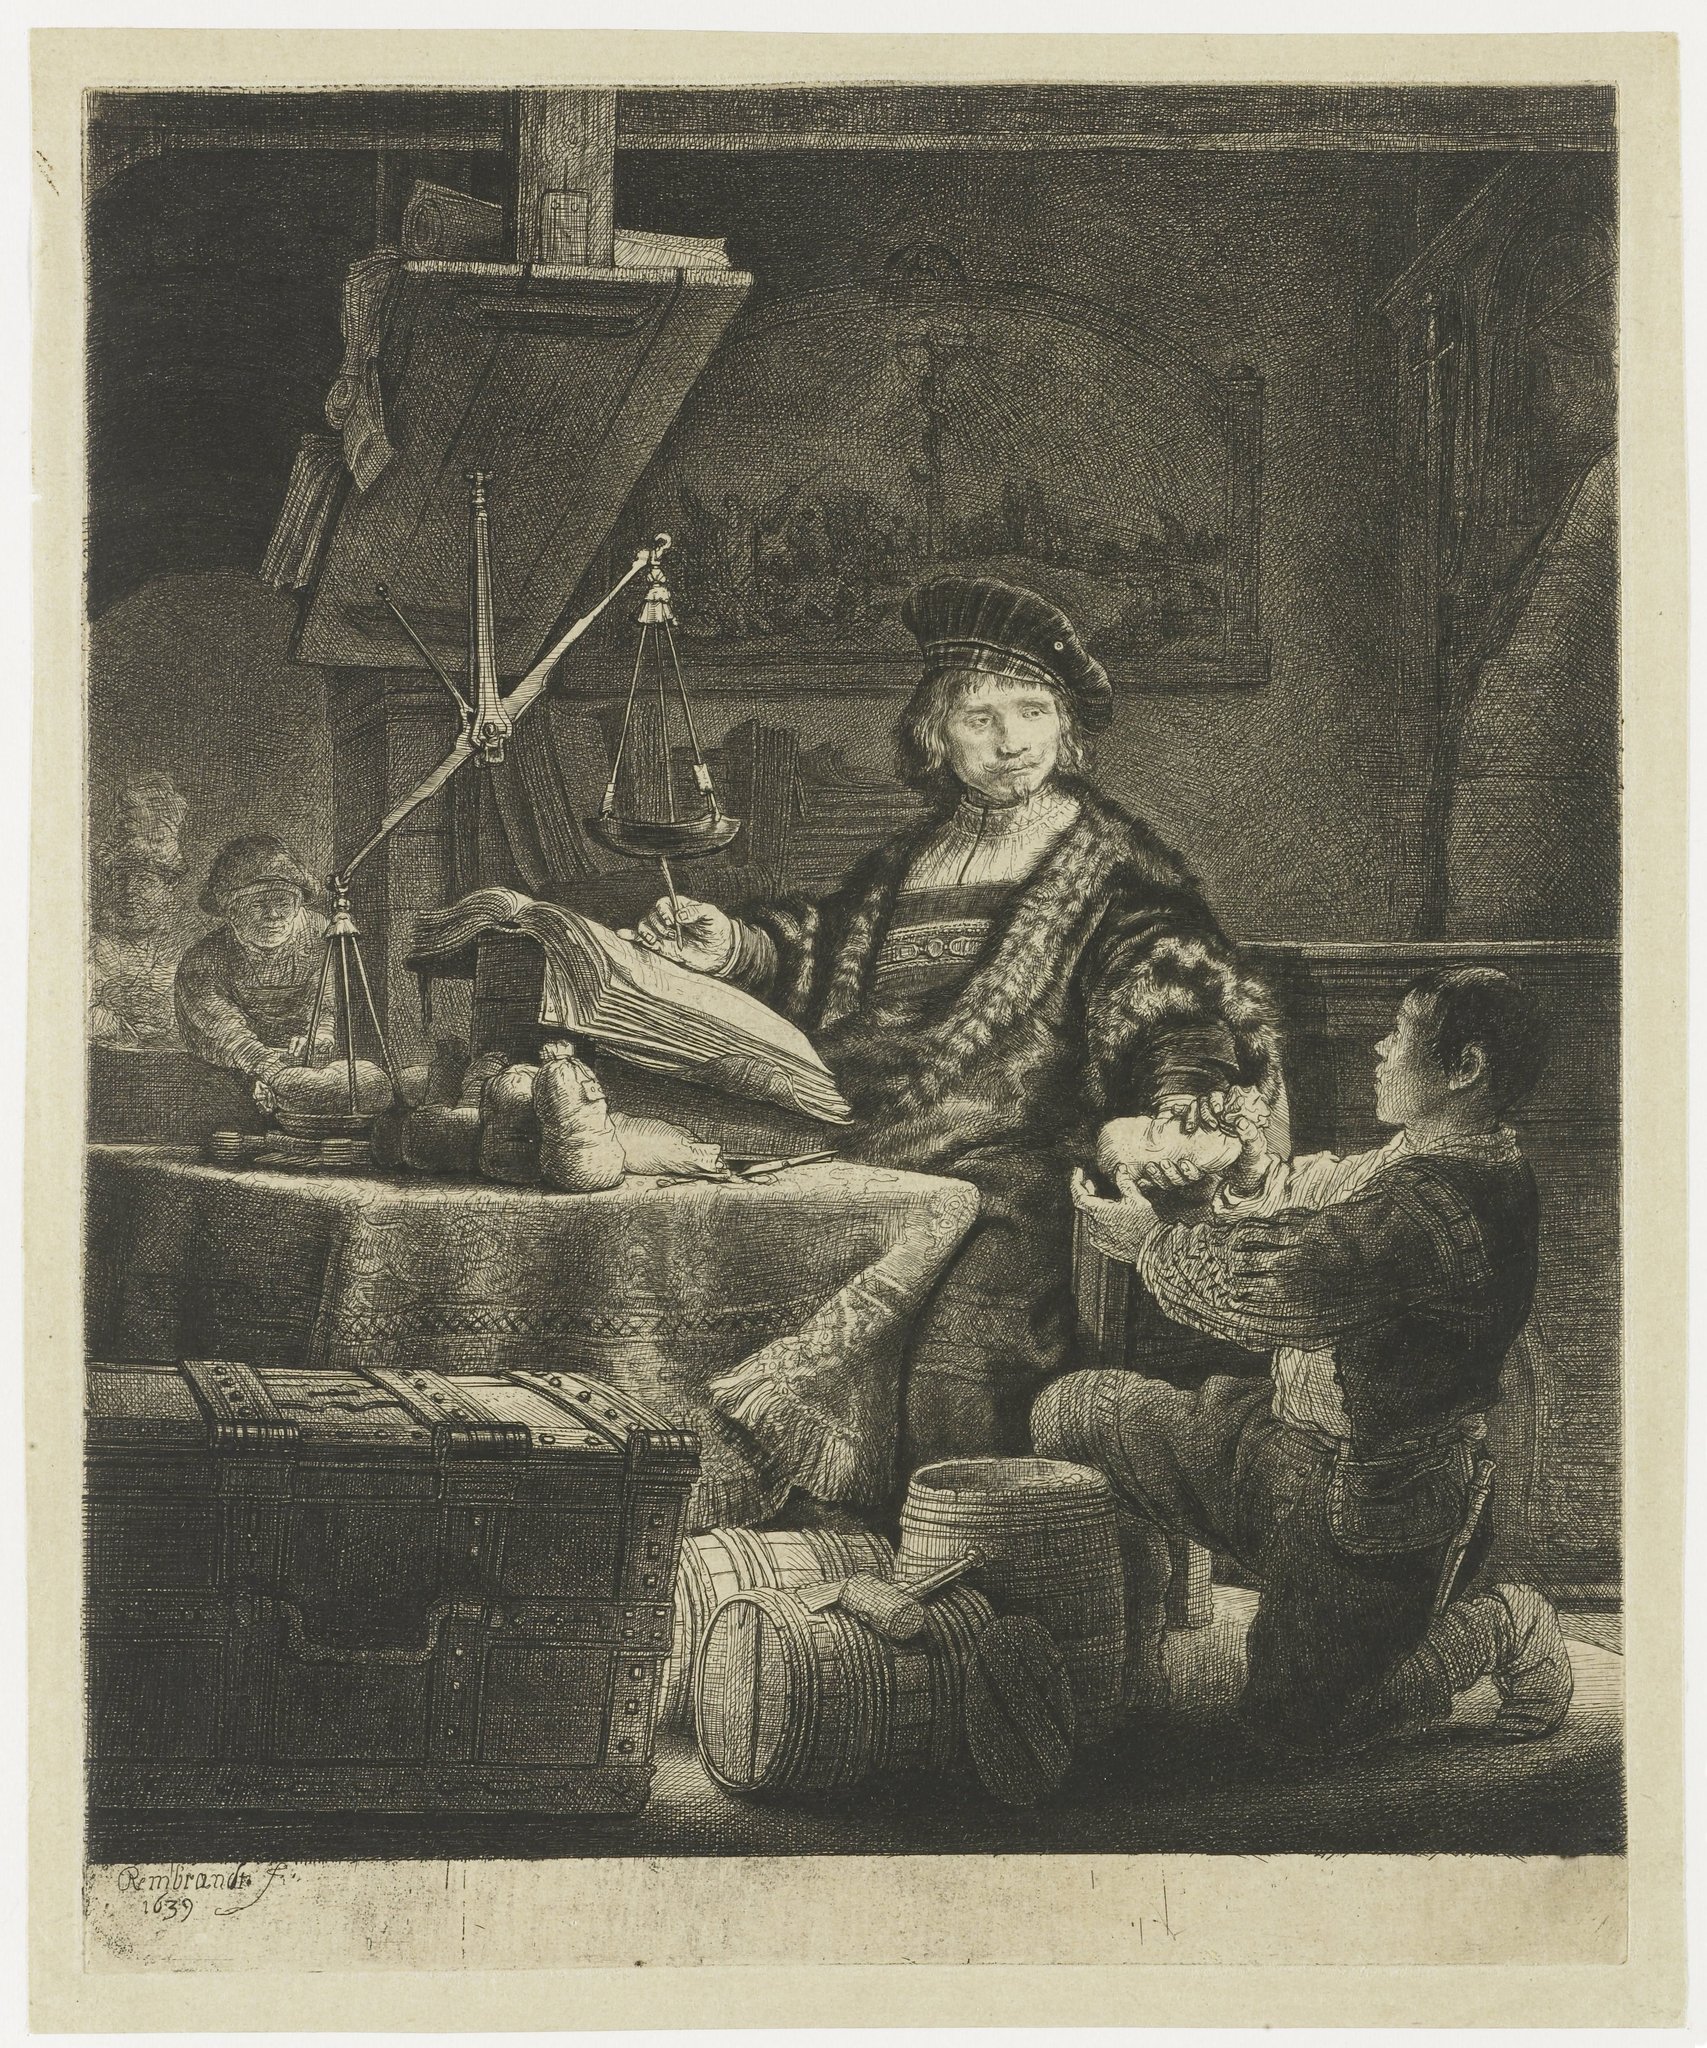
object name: print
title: Jan Uytenbogaert, 'the goldweigher'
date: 1639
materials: paper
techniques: drypoint, etching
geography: netherlands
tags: amsterdam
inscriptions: collector's mark: Lugt 2228, collector's mark: Lugt 300, collector's mark: ‘initialen van Campbell Dodgson’ Lugt 305, inscription: ‘C. 8736’, signature and date: ‘Rembrandt f 1639’